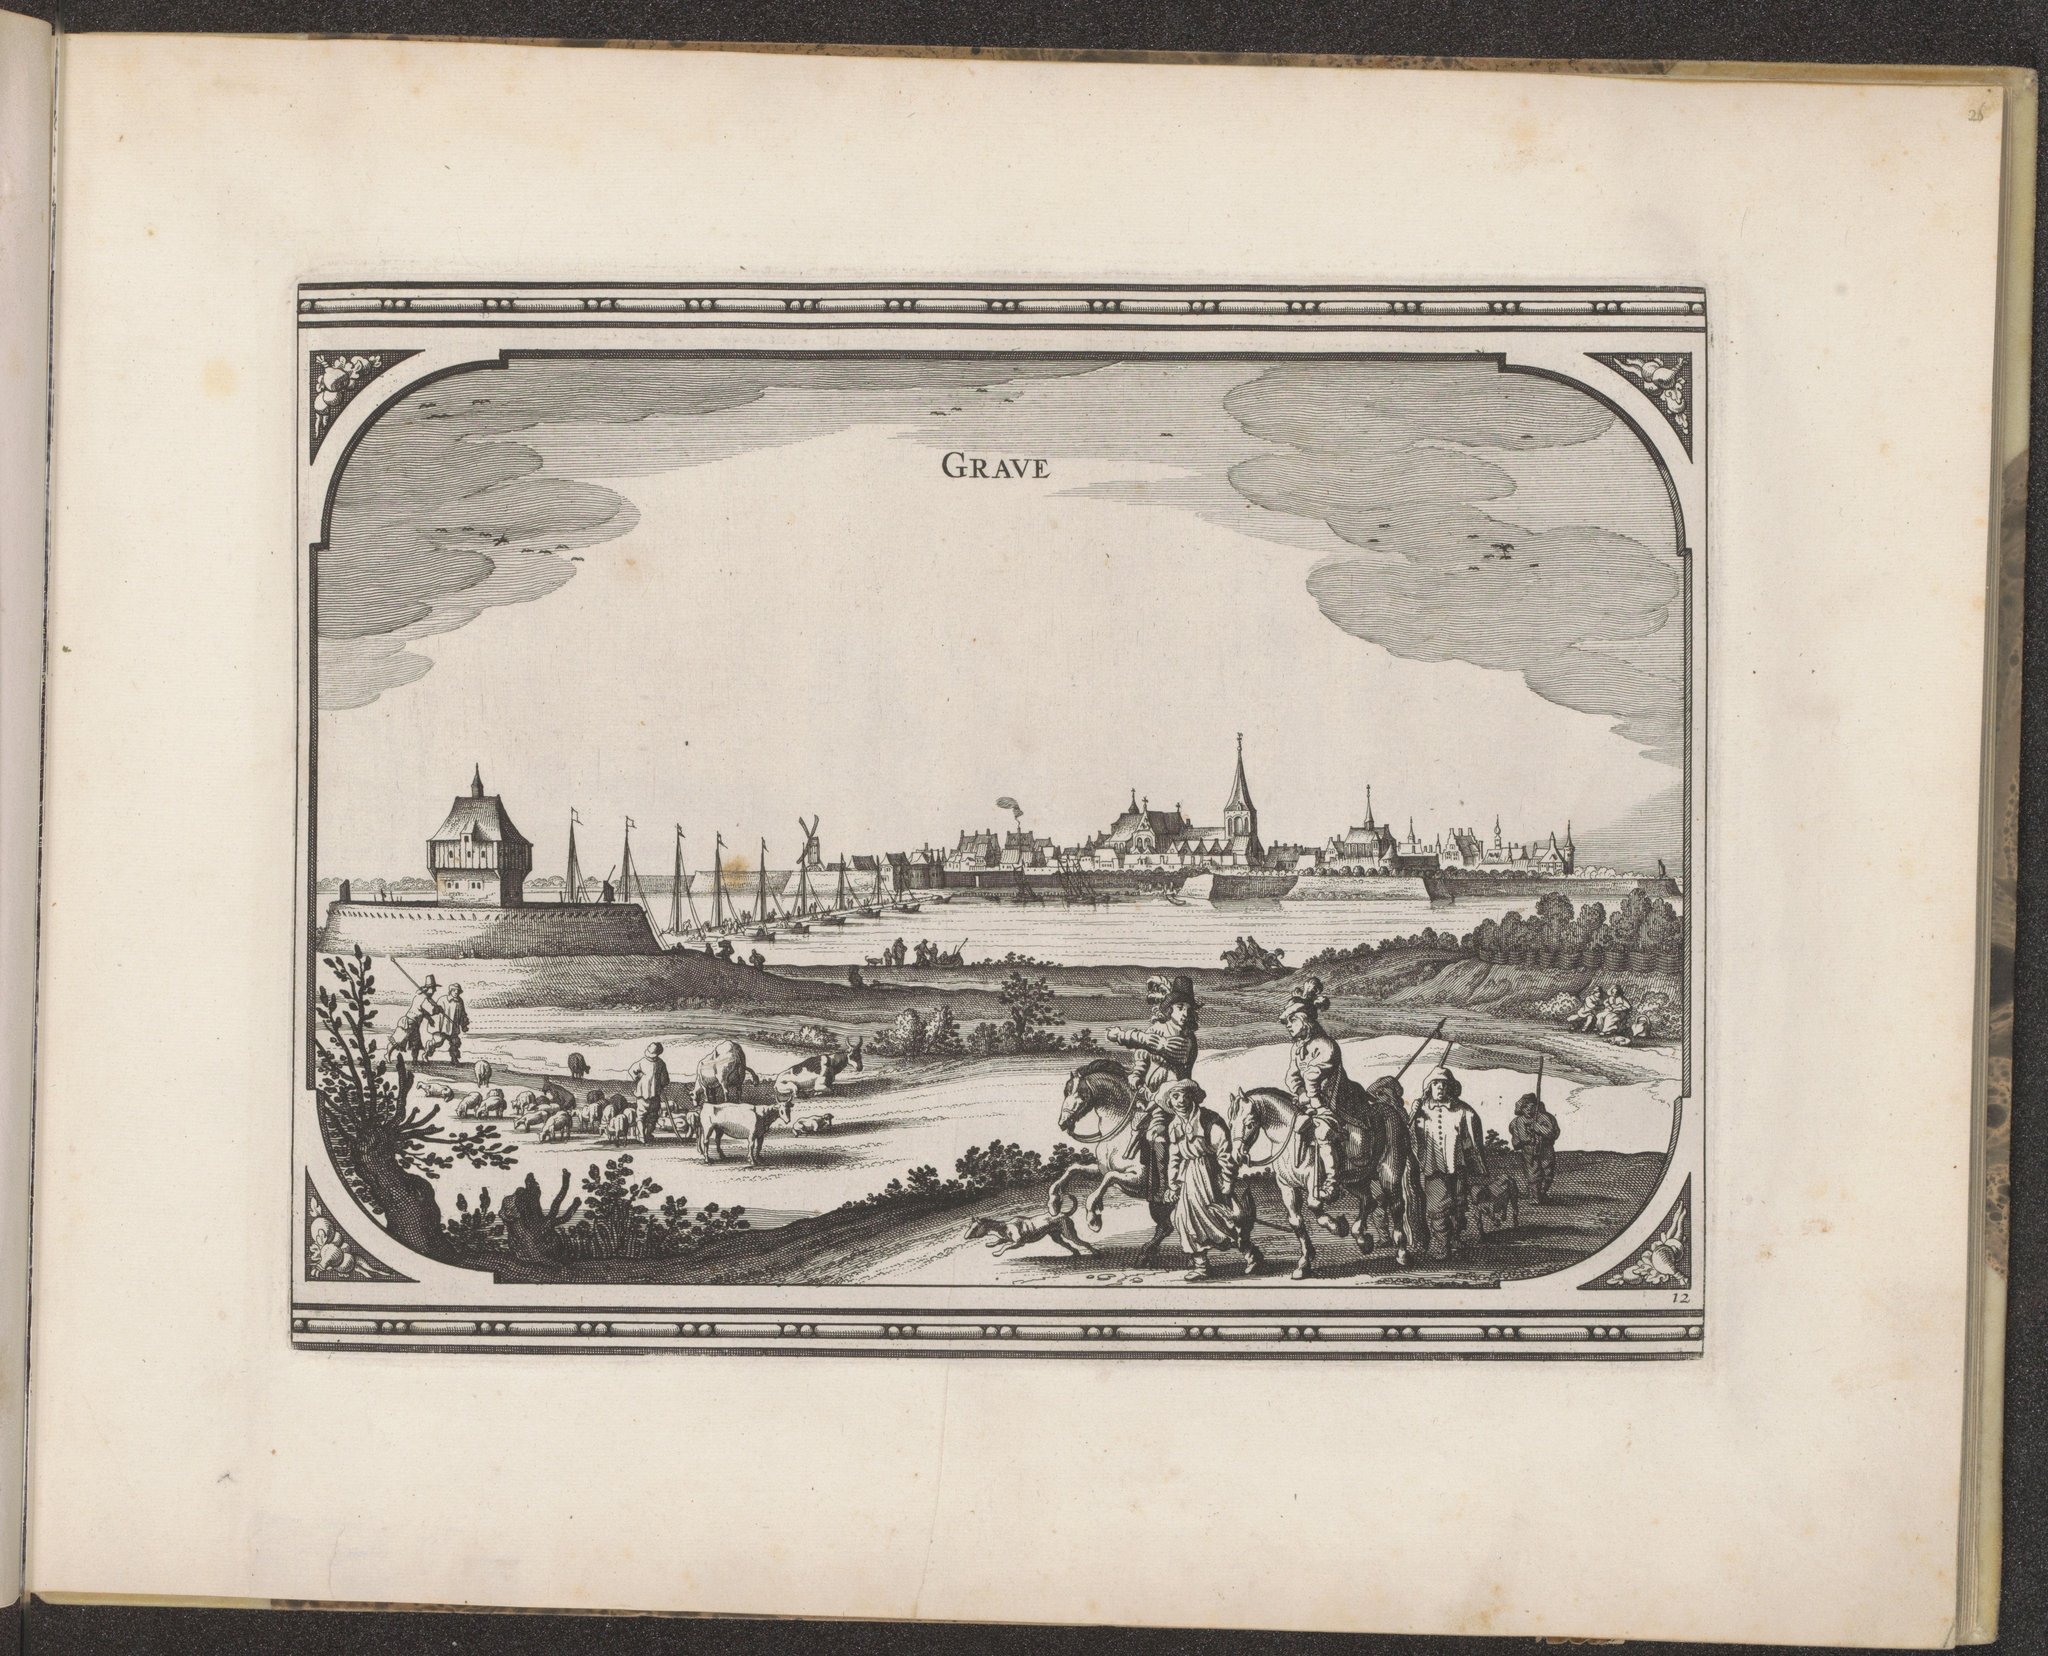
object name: print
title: Gezicht op Grave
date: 1660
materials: paper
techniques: etching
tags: city-view, and landscape with man-made constructions, hunting, chase, herding, herdsman, herdswoman, shepherd, shepherdess, cowherd, etc., grave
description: Gezicht op de stad Grave aan het water. De twee heren te paard zijn op jacht geweest. De man tussen hen in draagt twee ganzen. Links een herder. De prent maakt deel uit van een album.